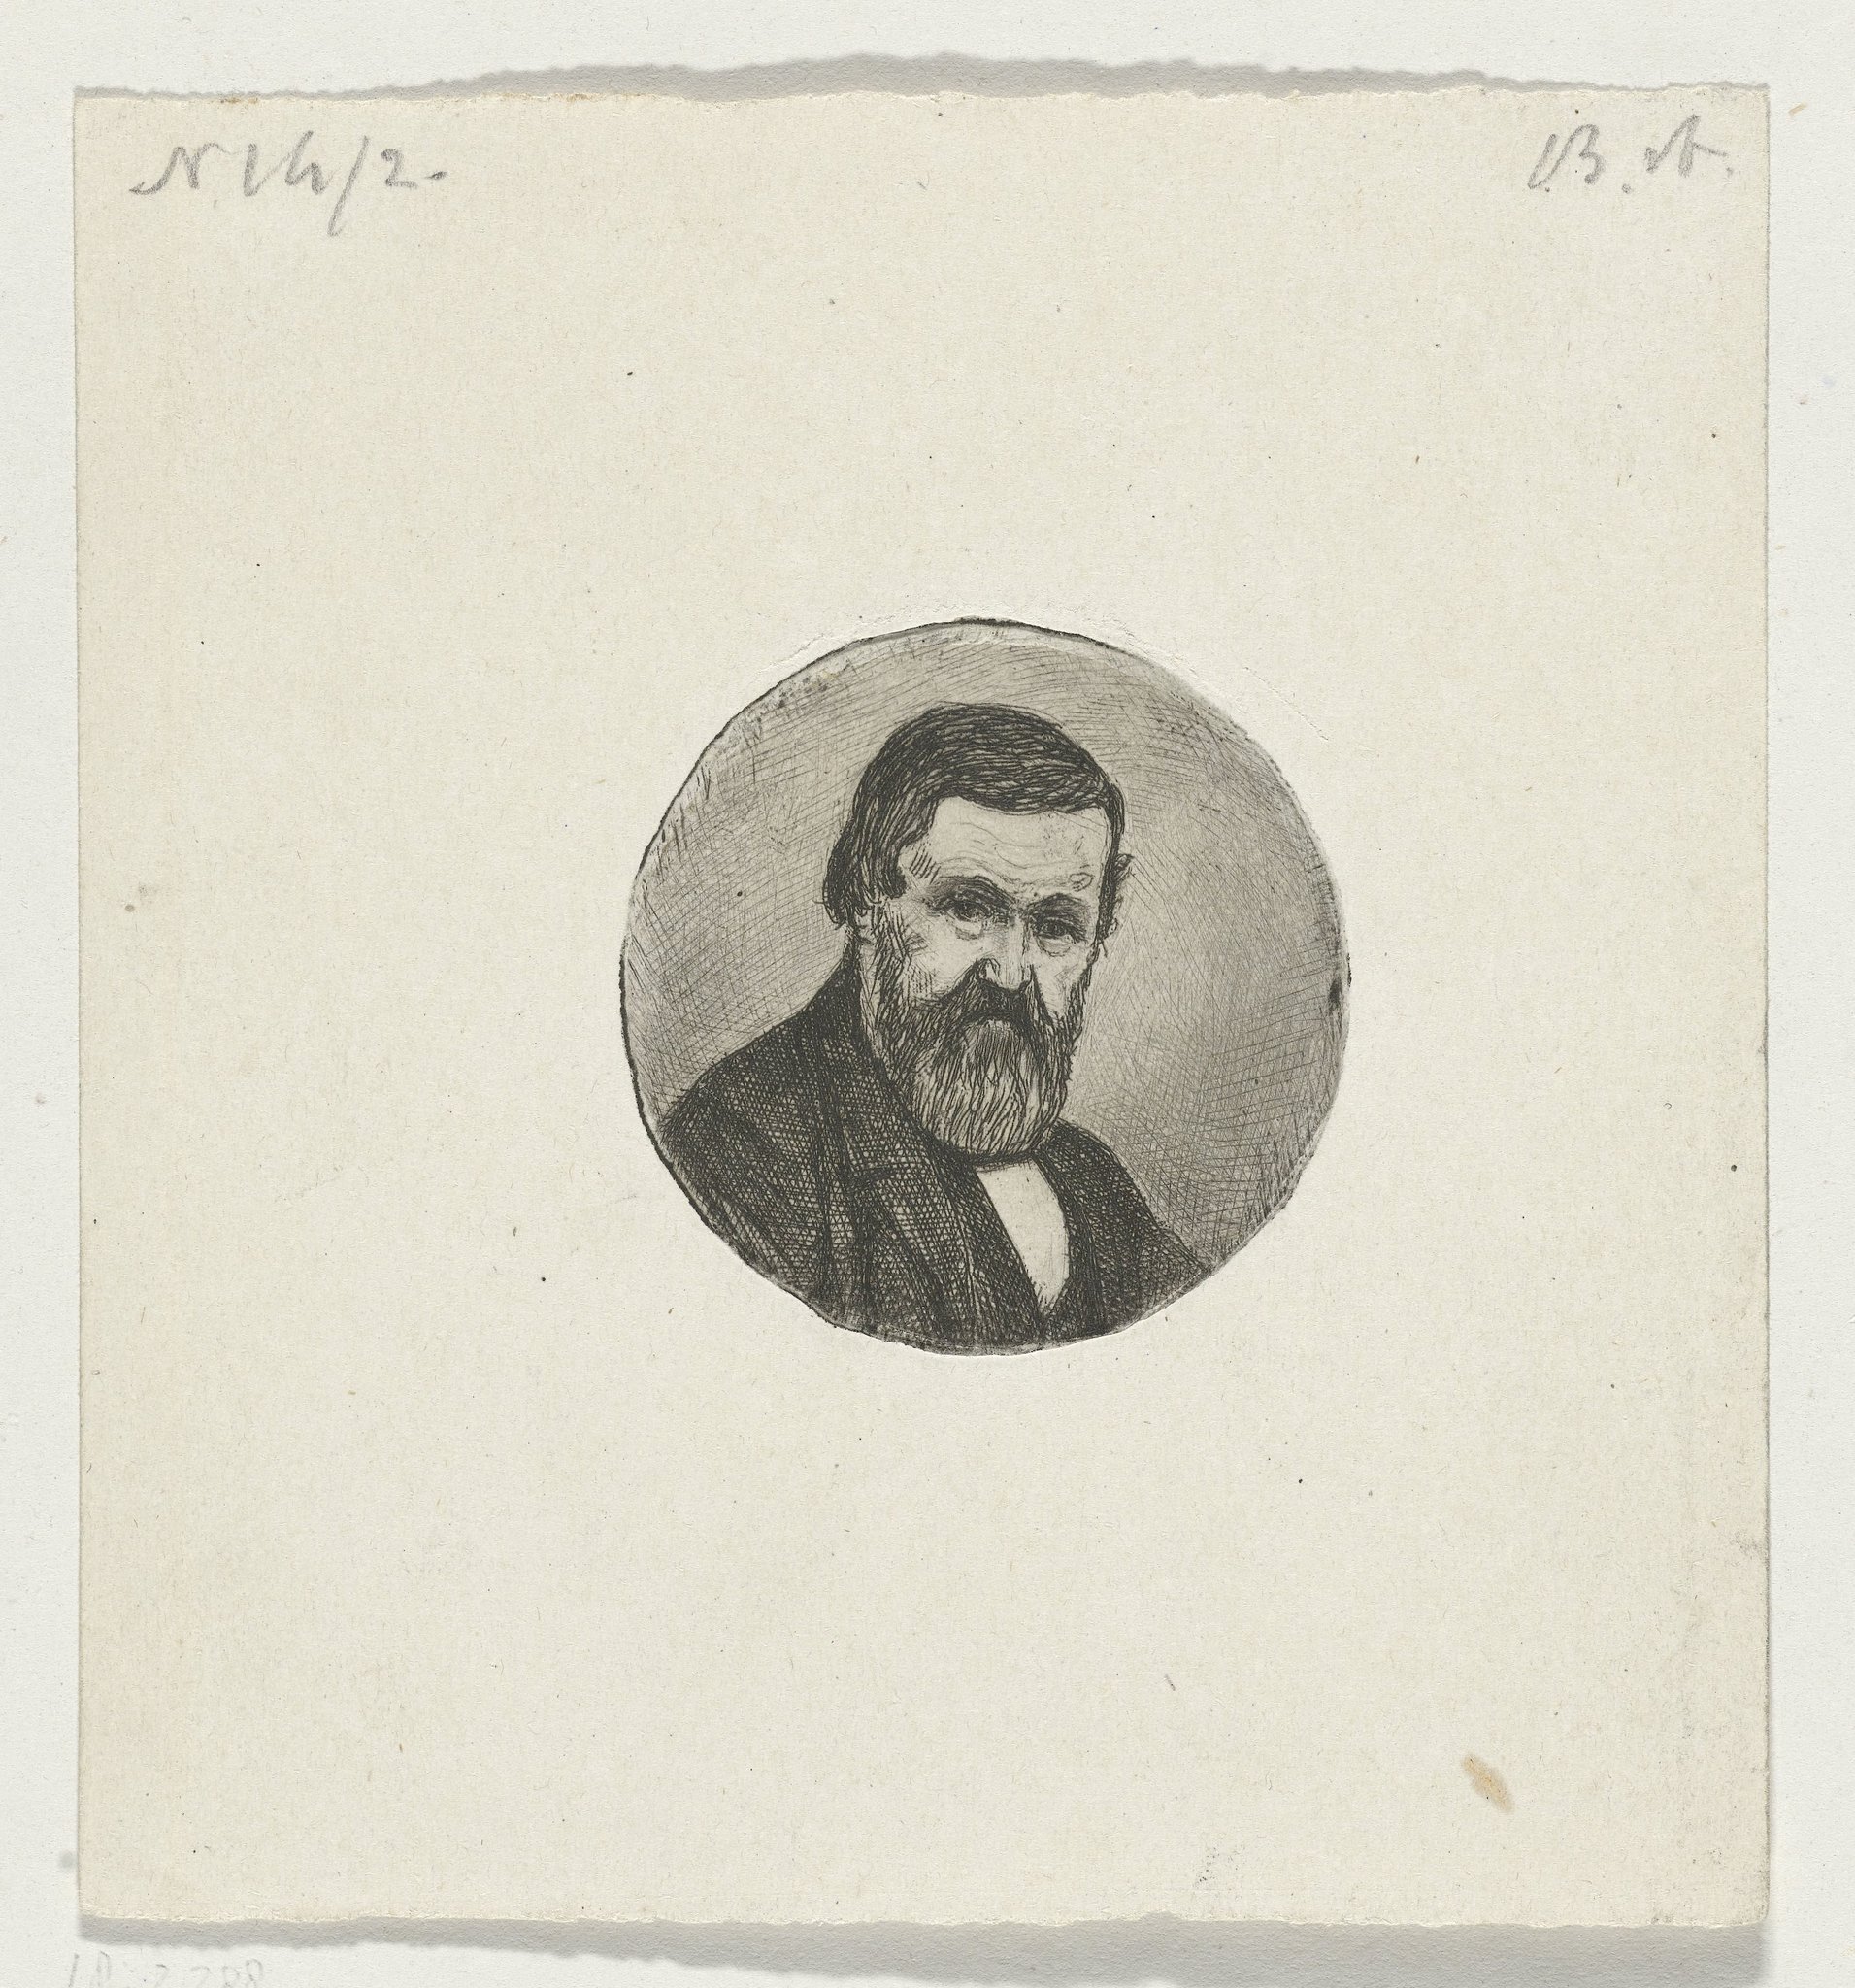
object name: print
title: Portret van Cornelis Ouboter van der Grient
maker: cornelis van der griendt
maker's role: draughtsman, painter, print maker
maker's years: 1827-1918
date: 1865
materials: paper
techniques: etching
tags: portrait, self-portrait of draughtsman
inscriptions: collector's mark: Lugt 2228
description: Portret in een ovaal van Cornelis Ouboter van der Grient, ten halven lijve.